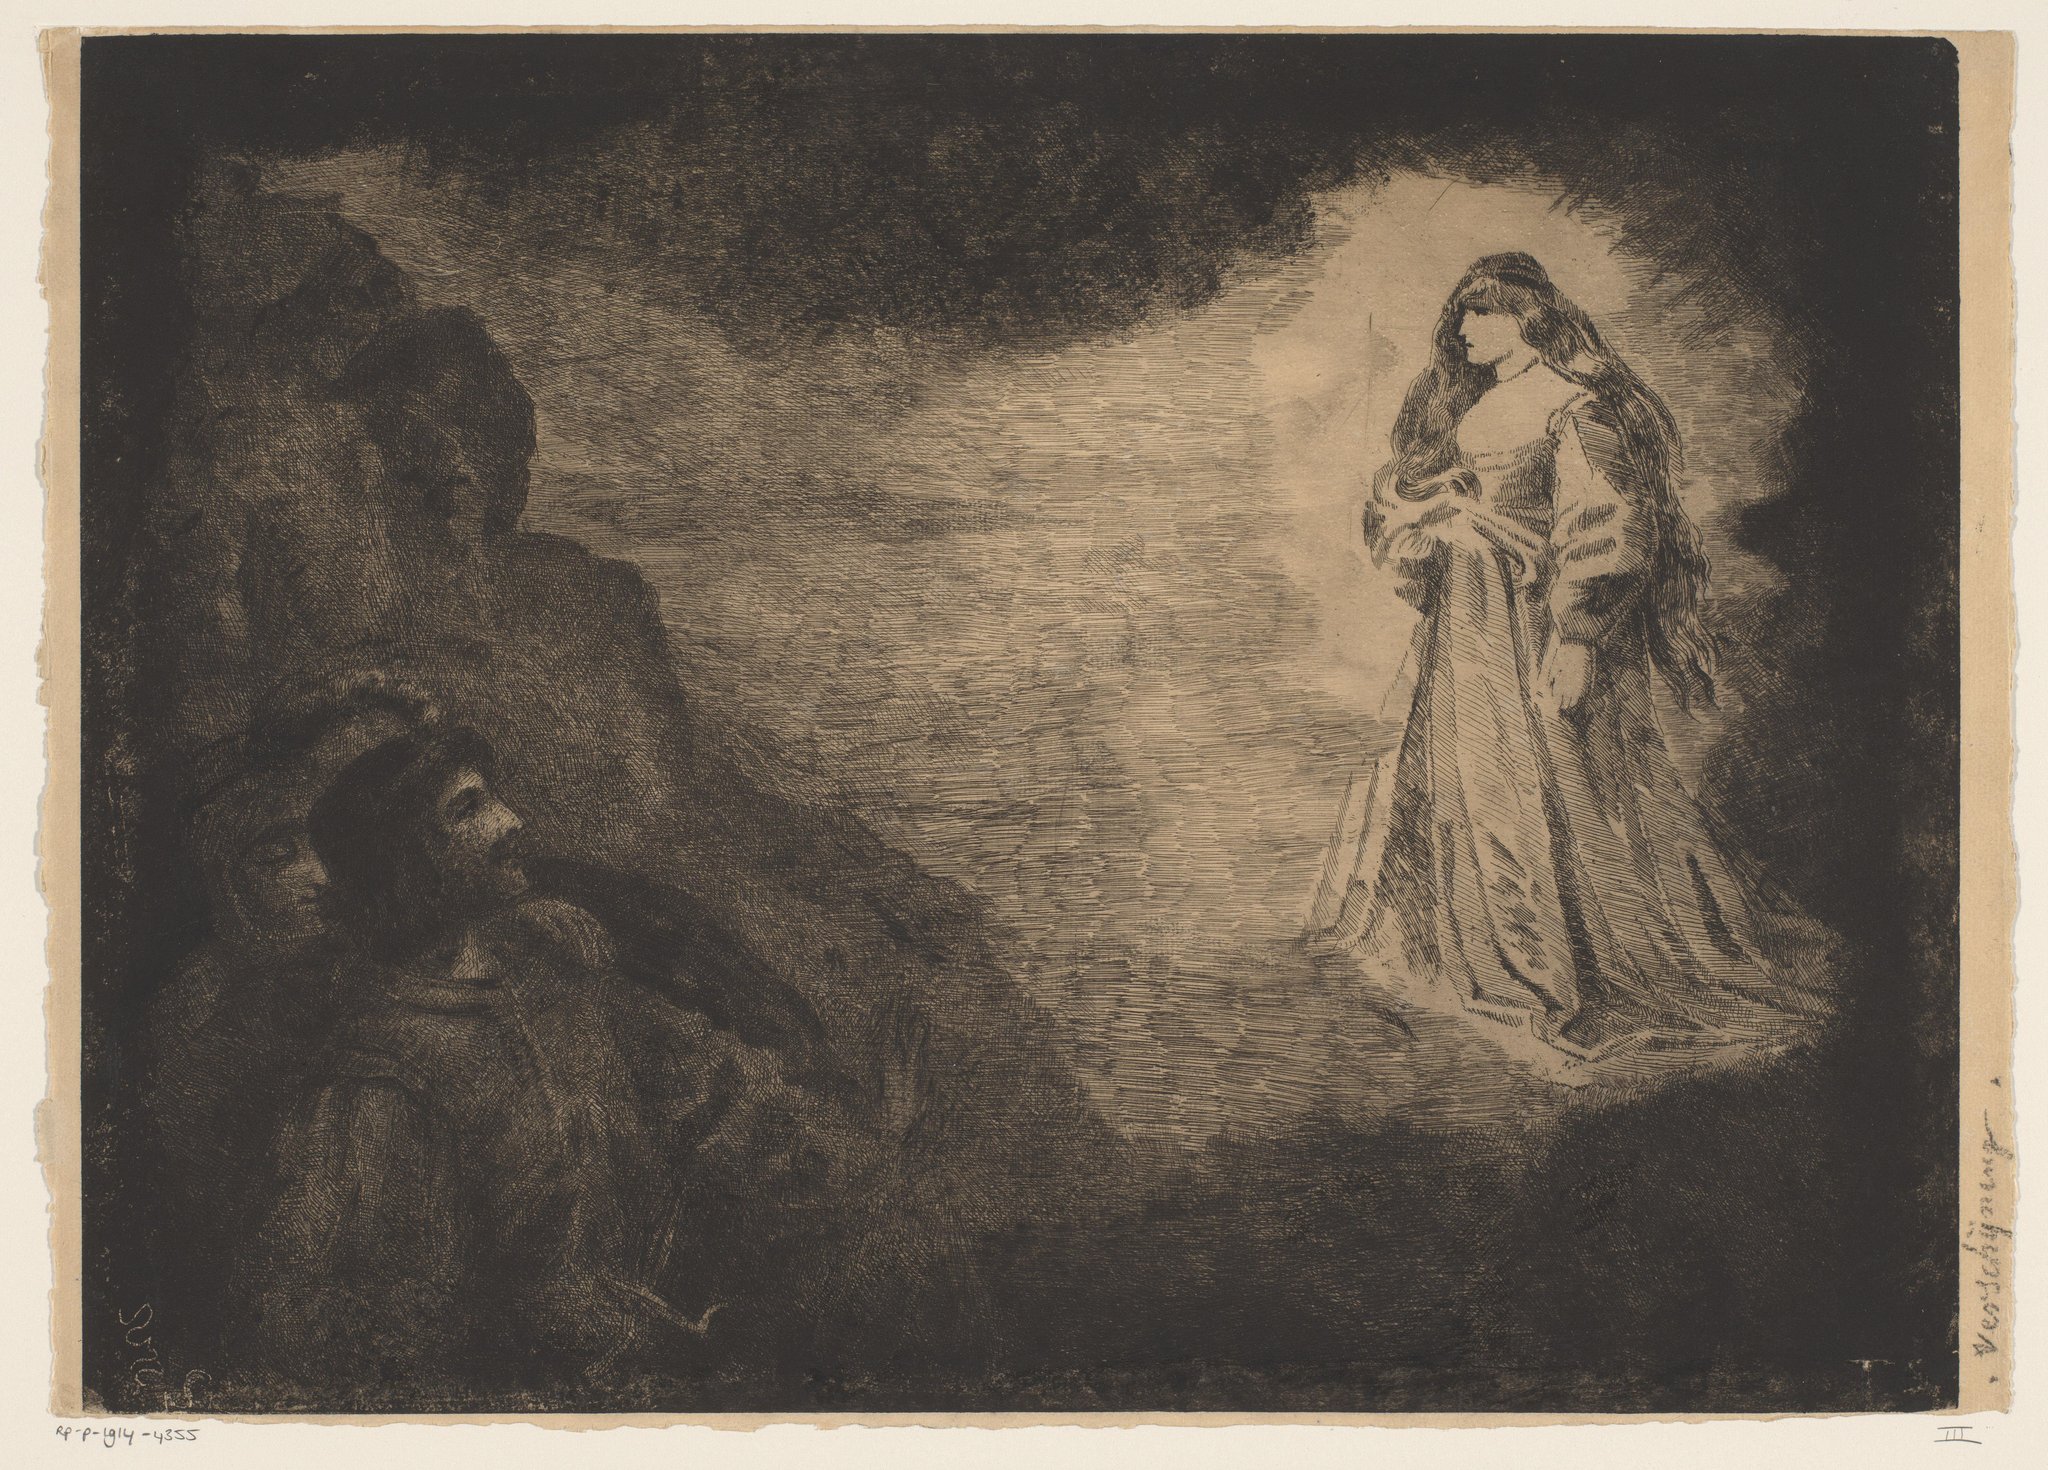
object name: print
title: Verschijning van Margarete aan Faust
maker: arnoud schaepkens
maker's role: print maker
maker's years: 1816-1904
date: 1831-1904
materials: paper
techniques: drypoint, etching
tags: (scenes from) specific works of literature: goethe, faust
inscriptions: collector's mark: Lugt 2228